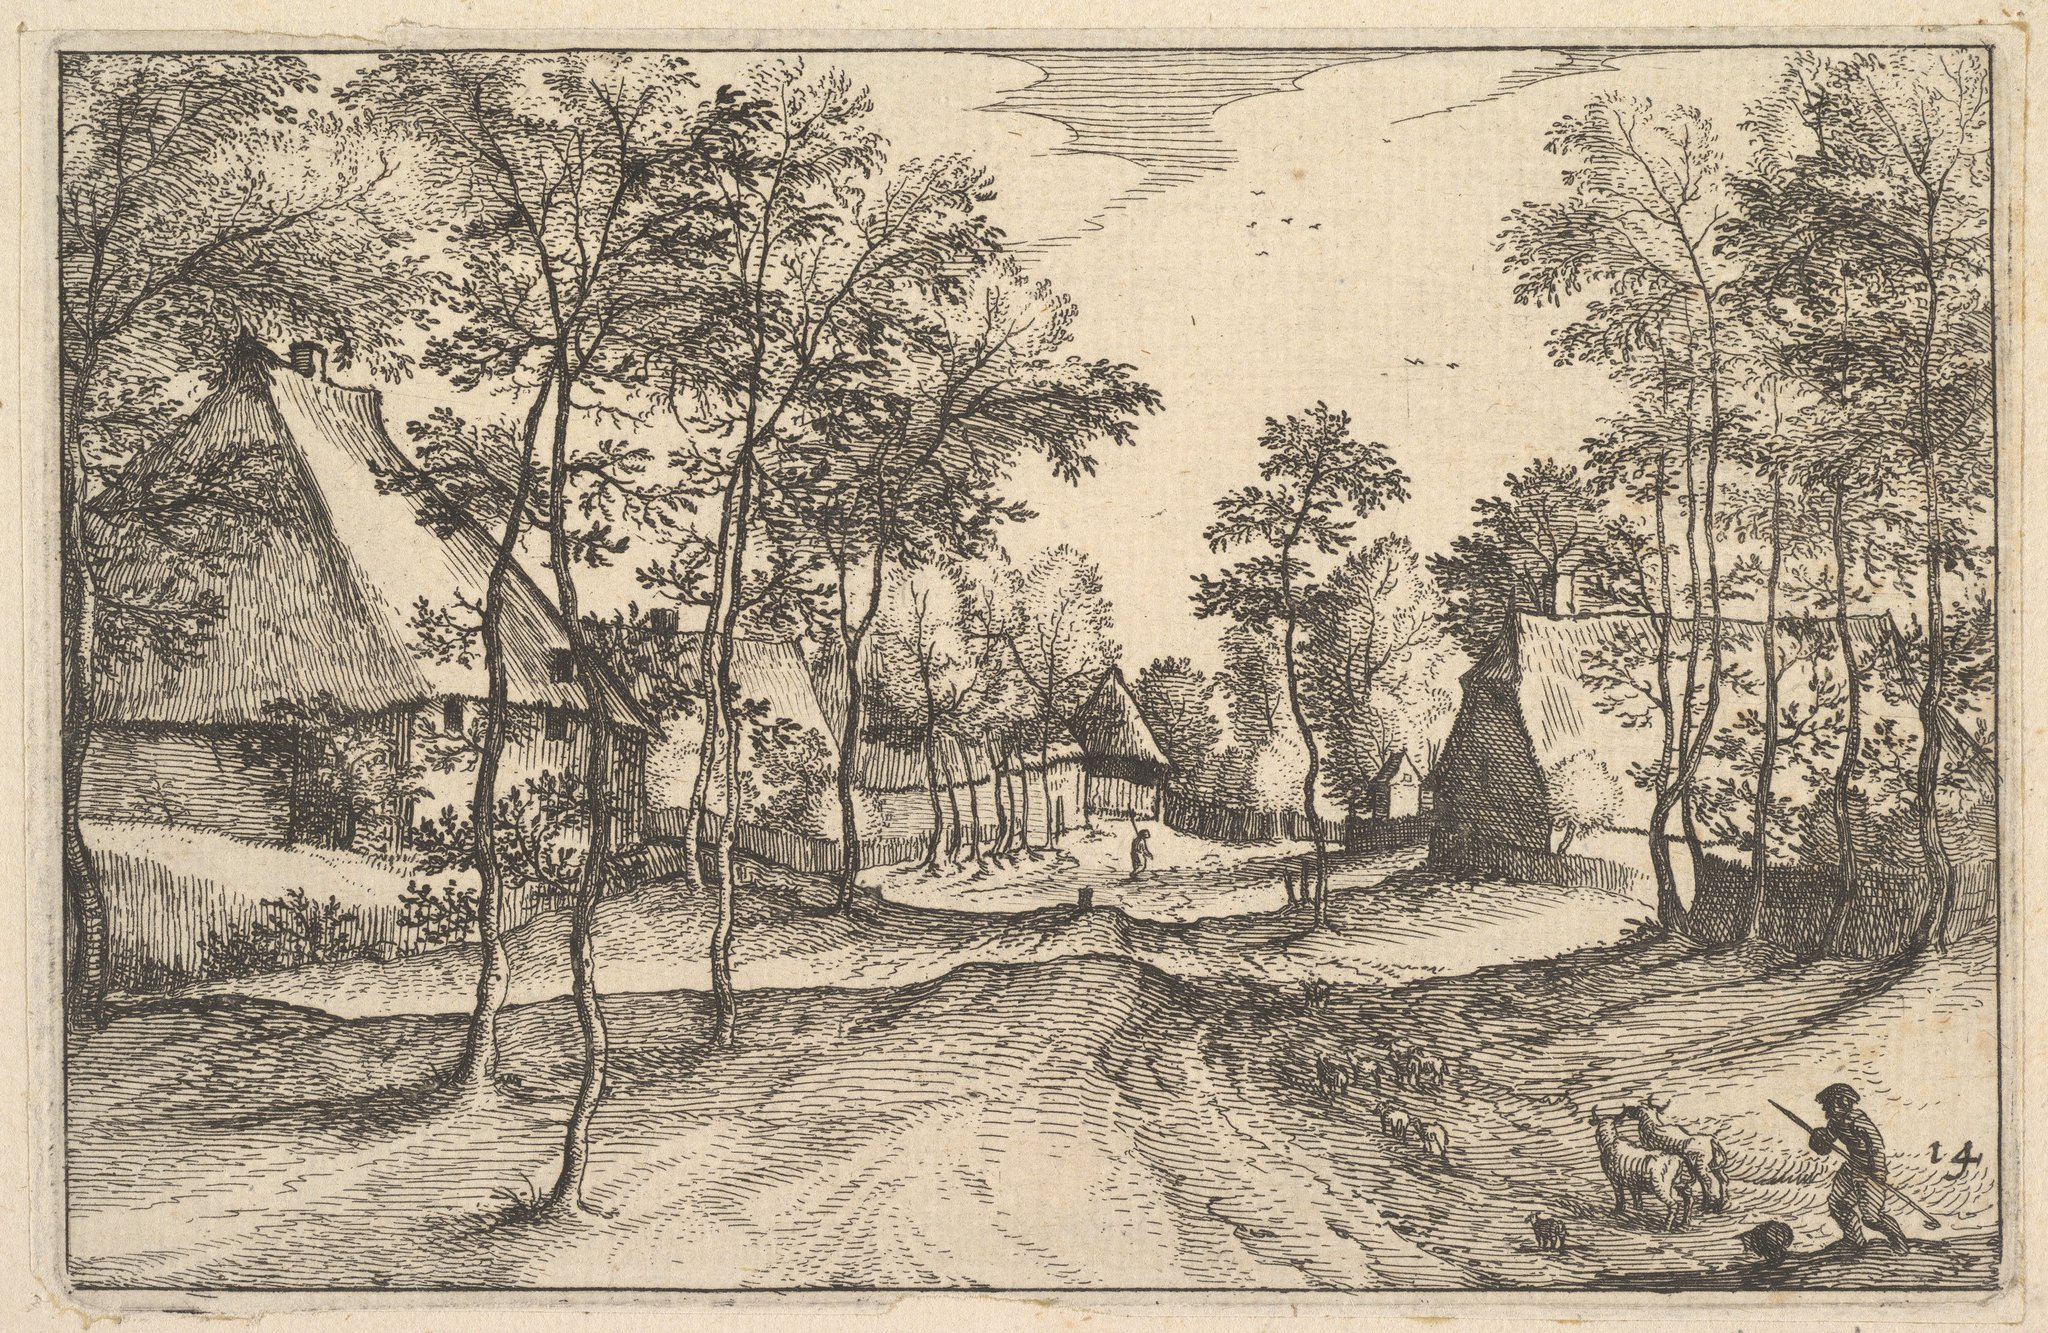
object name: print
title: A Village Road, plate 14 from "Regiunculae et Villae Aliquot Ducatus Brabantiae"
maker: claes jansz. visscher (ii)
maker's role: artist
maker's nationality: dutch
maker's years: 1586-1652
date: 1610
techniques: etching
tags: human figures,animals,houses,roads,villages